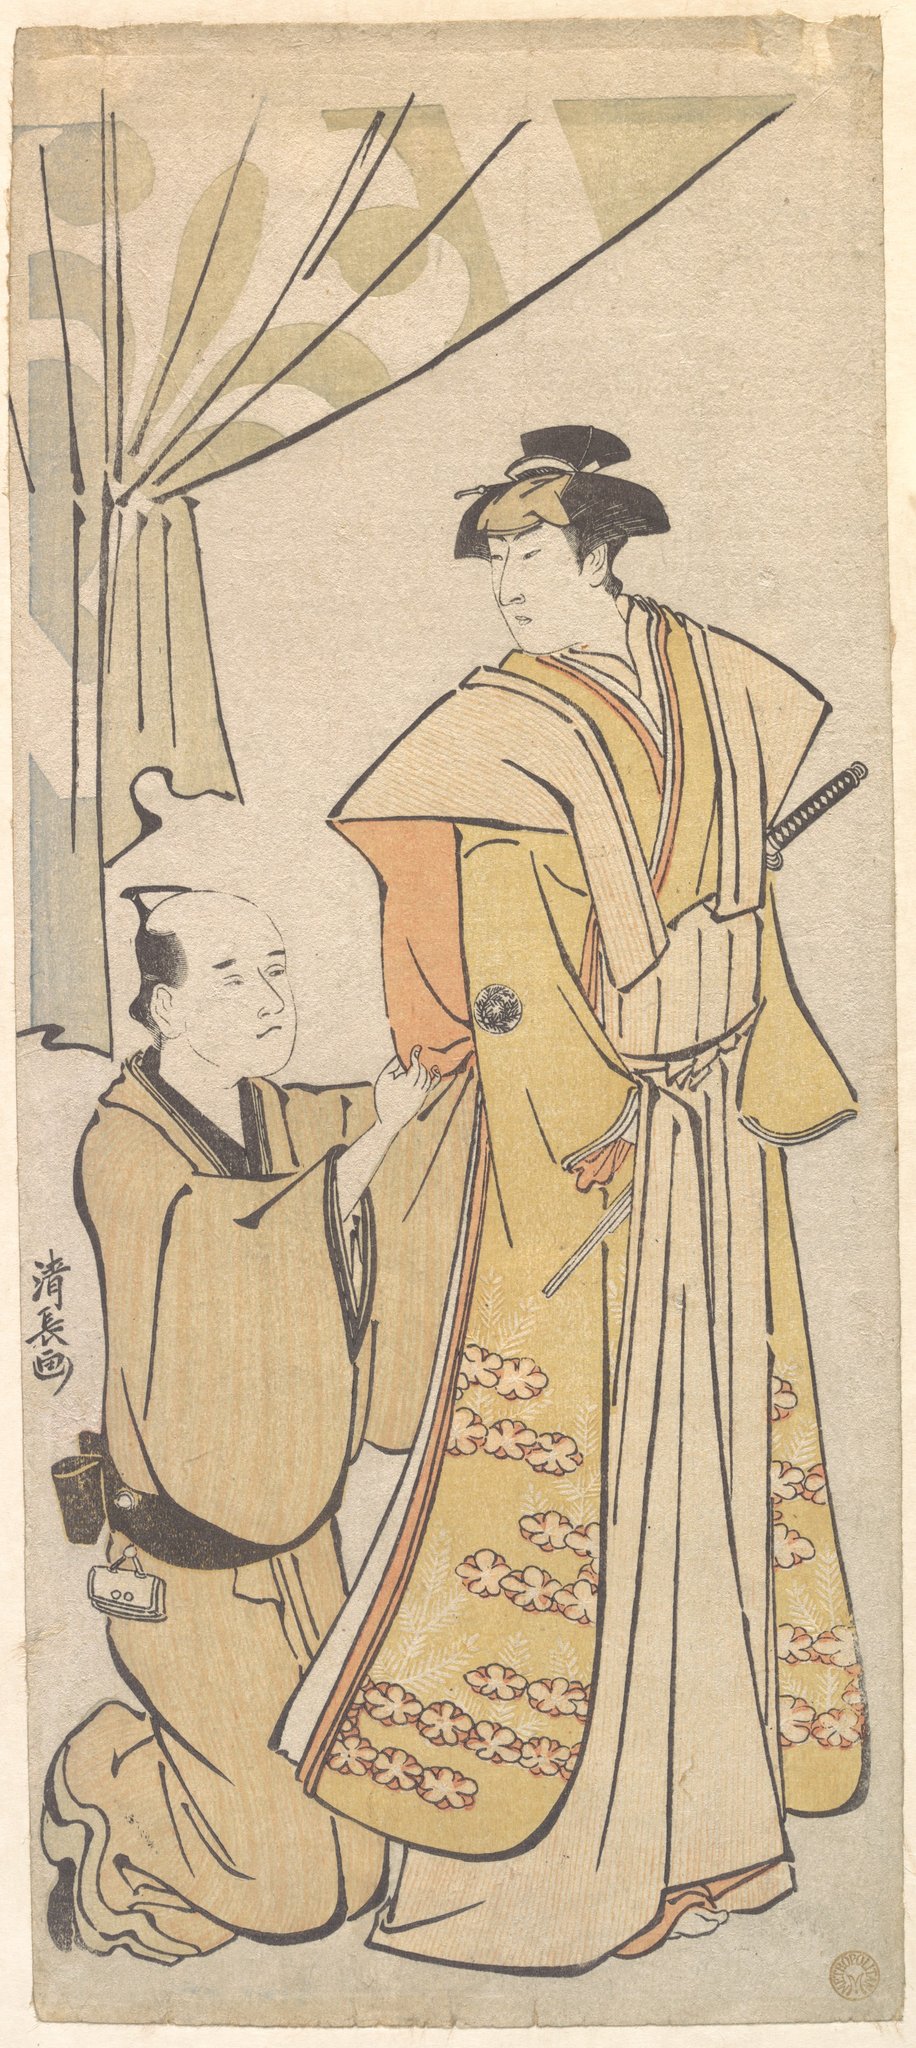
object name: print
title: The Actor Nakamura Rikō I with an Attendant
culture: japanese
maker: torii kiyonaga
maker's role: artist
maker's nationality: japanese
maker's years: 1752-1815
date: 1784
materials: ink, paper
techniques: woodblock print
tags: men,actors